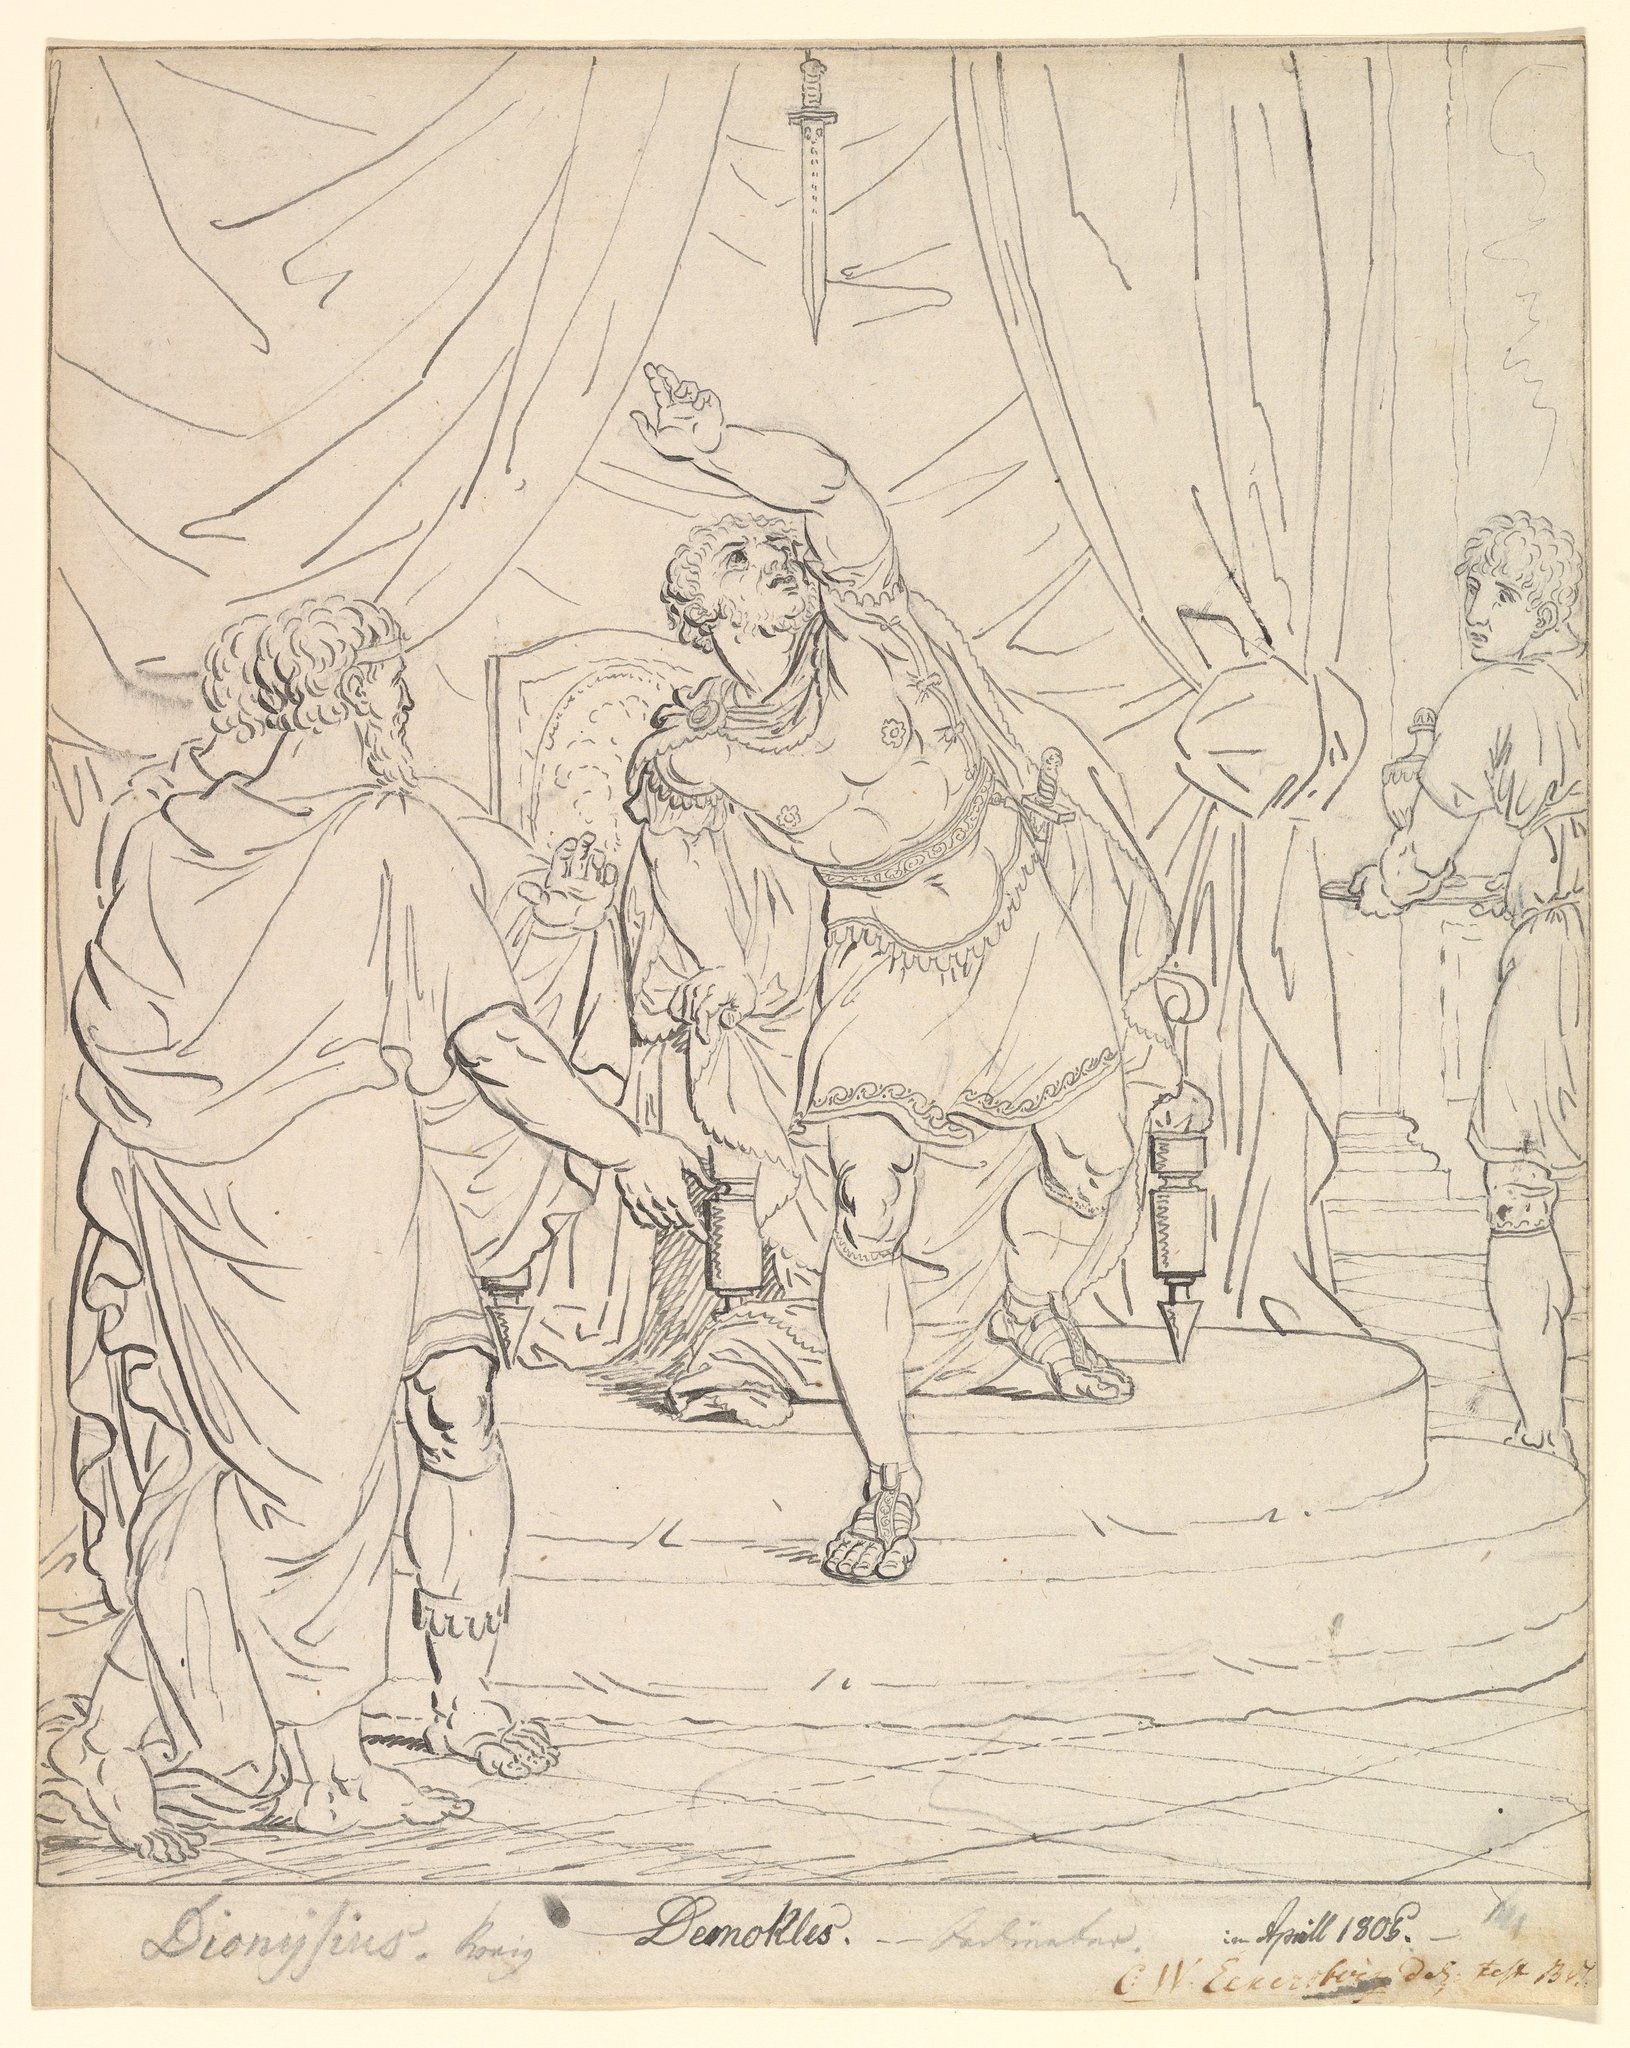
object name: drawing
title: The Sword of Damocles; verso: Sketches of Man's Head and of a Figure with a Raised Arm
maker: christoffer wilhelm eckersberg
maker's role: artist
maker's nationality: danish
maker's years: 1783-1853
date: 1805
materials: graphite, ink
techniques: pen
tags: swords,men